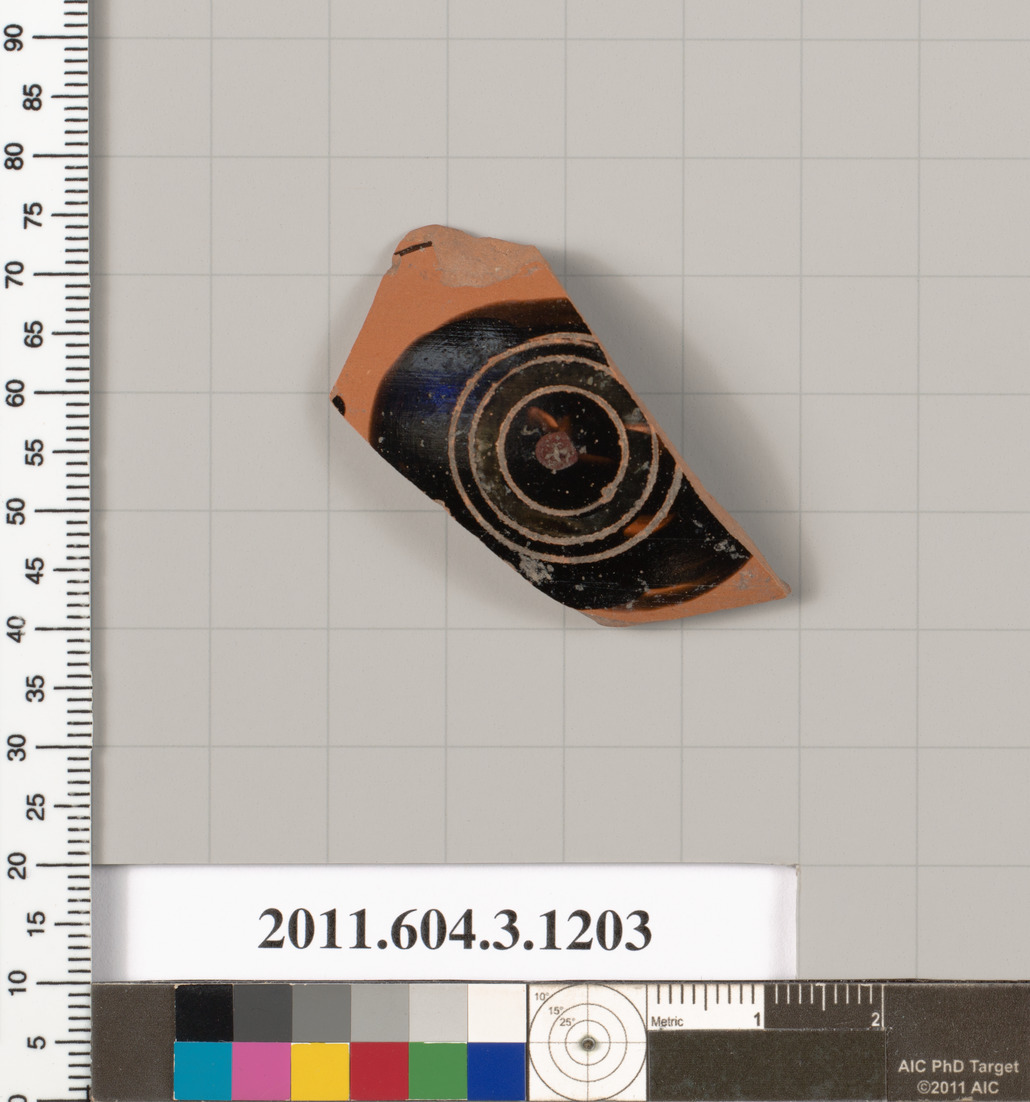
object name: mastoid fragment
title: Terracotta fragment of a mastoid (drinking cup with narrow base)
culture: greek, attic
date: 534-468 BCE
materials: terracotta